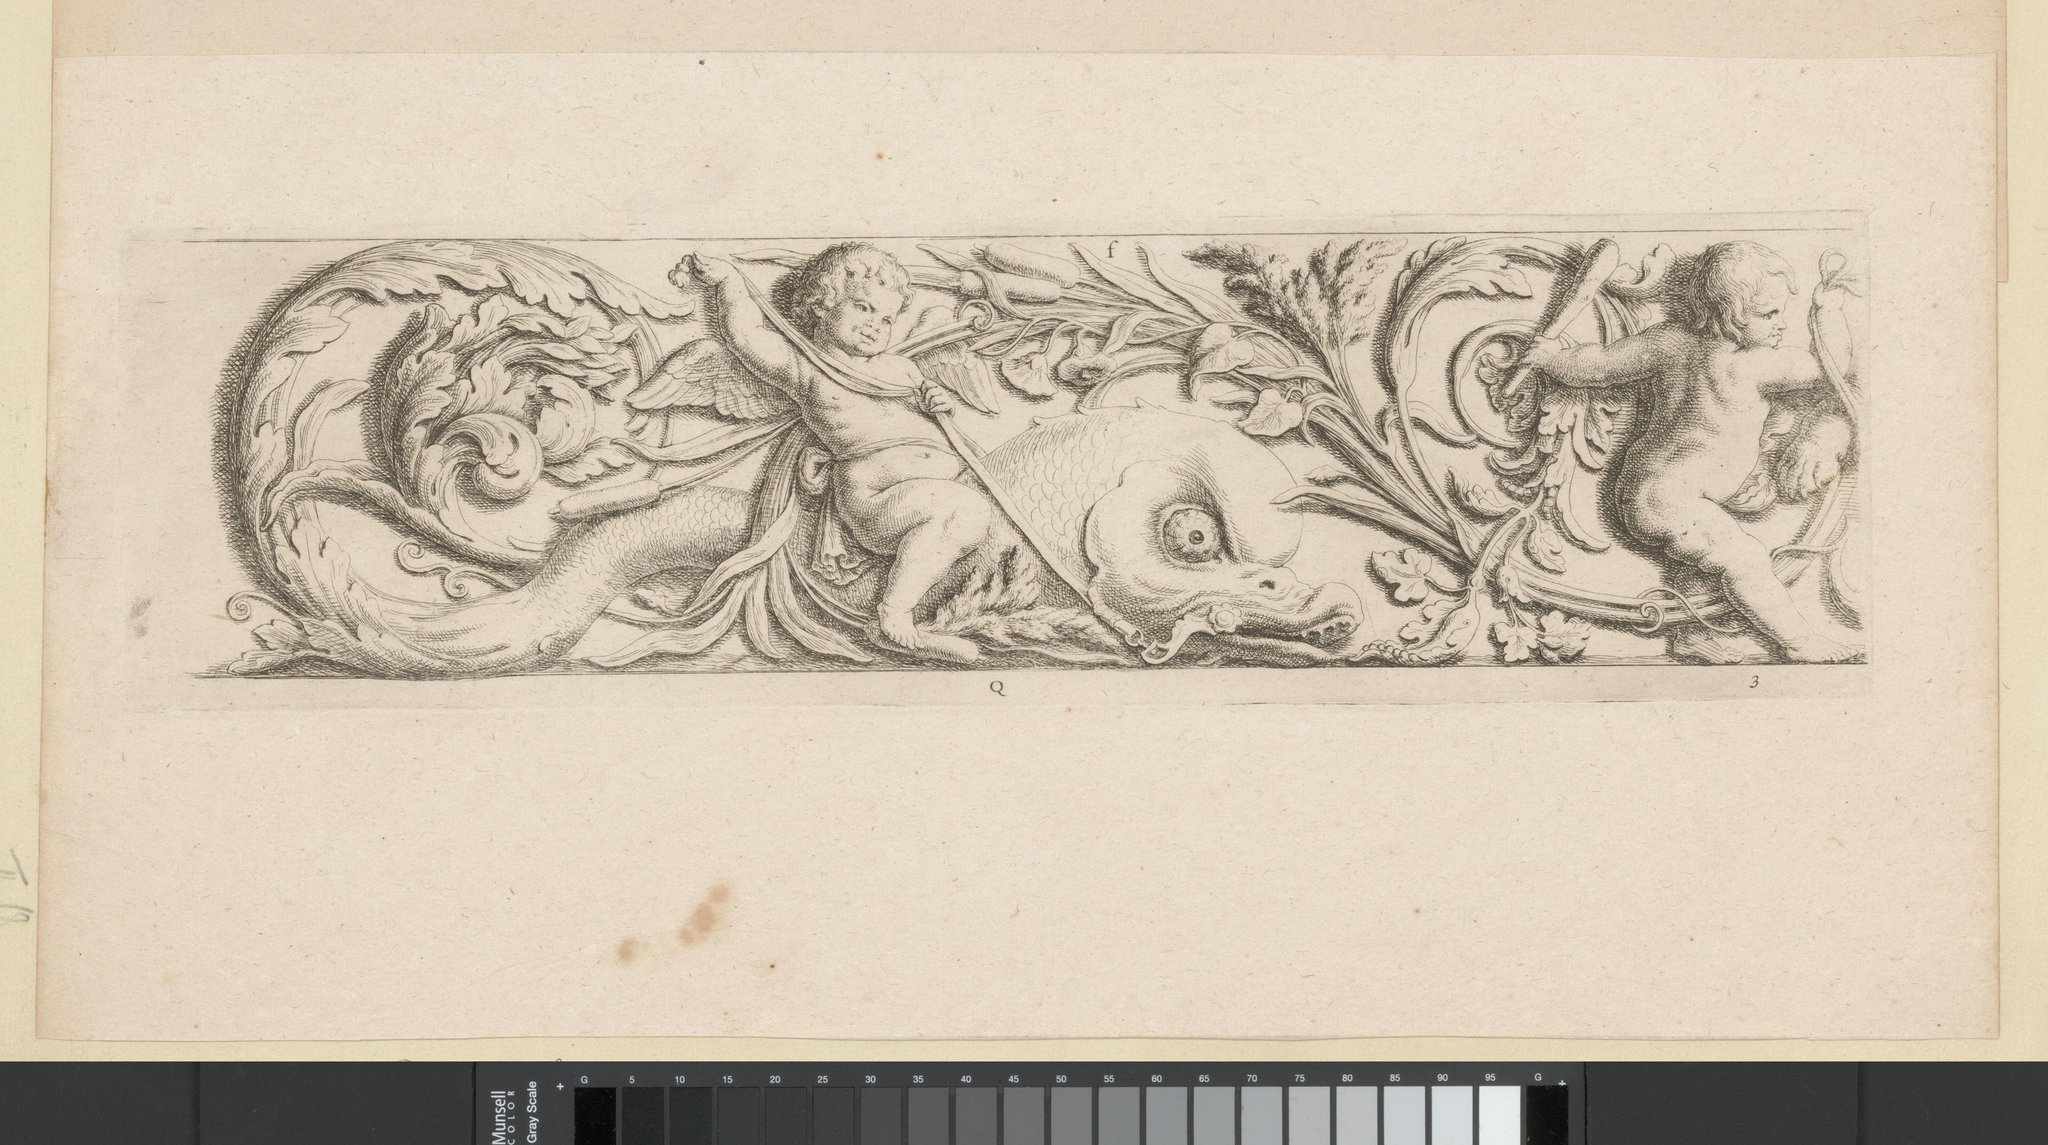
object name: print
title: Deel van fries op schouw in Vroedschapskamer van het Stadhuis op de Dam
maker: hubert quellinus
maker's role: print maker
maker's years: 1619-1687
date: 1663-1668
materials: paper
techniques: engraving, etching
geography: amsterdam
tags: dolphin ~ ornament, swimming mammals: dolphin, townhall, allegory, personification of good government, cupids: 'amores', 'amoretti', 'putti'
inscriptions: collector's mark: ‘16,84’ Lugt 1641b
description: Prent gebruikt in: Secunca pars Praecipuarum effigierum ac ornamentorum amplissime Curiae Amstelrodamensis maiori ex parte in cadido marmore effectorum per Artum Quellinium eiusdem Civitatis Statuarium / Het tweede deel Van de voornaemste Statuen ende Cieraten van 't konst-rijcke Stadt-huys van Amstelredam 'tmeeste in Marmer gemaeckt door Artus Quellinus Beelthouwer der voorseyde Stadt. Amsterdam: Artus Quellinus (I), 1663. Zie RP-P-AO-22-2-1 voor bijhorende titelpagina. Zie RP-P-AO-22-2-2 voor bijhorend register. Zie RP-P-AO-22-2A, RP-P-AO-22-2B, RP-P-AO-22-2C-1, RP-P-AO-22-2C-2, RP-P-AO-22-2C-3, RP-P-AO-22-2C-4, RP-P-AO-22-2D-1, RP-P-AO-22-2D-2, RP-P-AO-22-2D-3, RP-P-AO-22-2E-1, RP-P-AO-22-2E-2, RP-P-AO-22-2E-3, RP-P-AO-22-2E-4, RP-P-AO-22-2F-1, RP-P-AO-22-2F-2, RP-P-AO-22-2F-3, RP-P-AO-22-2G, RP-P-AO-22-2H, RP-P-AO-22-2I, RP-P-AO-22-2K, RP-P-AO-22-2L, RP-P-AO-22-2M, RP-P-AO-22-2N, RP-P-AO-22-2O-1, RP-P-AO-22-2O-2, RP-P-AO-22-2O-3, RP-P-AO-22-2O-4, RP-P-AO-22-2O-5, RP-P-AO-22-2O-6, RP-P-AO-22-2O-7, RP-P-AO-22-2P-1, RP-P-AO-22-2P-2, RP-P-AO-22-2Q-1, RP-P-AO-22-2Q-2, RP-P-AO-22-2R-1, RP-P-AO-22-2R-2, RP-P-AO-22-2R-3, RP-P-AO-22-2S, RP-P-AO-22-2T-1, RP-P-AO-22-2T-2, RP-P-AO-22-2T-3, RP-P-AO-22-2T-4, RP-P-AO-22-2V-1, RP-P-AO-22-2V-2, RP-P-AO-22-2W-1, RP-P-AO-22-2W-2, RP-P-AO-22-2X-1, RP-P-AO-22-2X-2 en RP-P-AO-22-2X-3 voor andere prenten uit deze publicatie. Zelfde staat van prent ook gebruikt in: Secunca pars Praecipuarum effigierum ac ornamentorum amplissime Curiae Amstelrodamensis maiori ex parte in cadido marmore effectorum per Artum Quellinium eiusdem Civitatis Statuarium / Het tweede deel Van de voornaemste Statuen ende Cieraten van 't konst-rijcke Stadt-huys van Amstelredam 'tmeeste in Marmer gemaeckt door Artus Quellinus Beelthouwer der voorseyde Stadt. Amsterdam: Frederik de Wit, 1668. Latere staat van prent ook gebruikt in: Architecture peinture et sculpture de la Maison de Ville d'Amsterdam, representee en CIX. figures en taille-douce (…). Amsterdam: David Mortier, 1719. En in: Architecture peinture et sculpture de la Maison de Ville d'Amsterdam, representee en CIX. figures en taille-douce (…). Amsterdam: Gerard Valck, 1719. En in: Bouw schilder en beeldhouwkonst, van het Stadhuis te Amsteldam, vertoont in CIX figuuren (…). Amsterdam: Covens & Mortier & Covens Jr., s.a. (1774-1783).